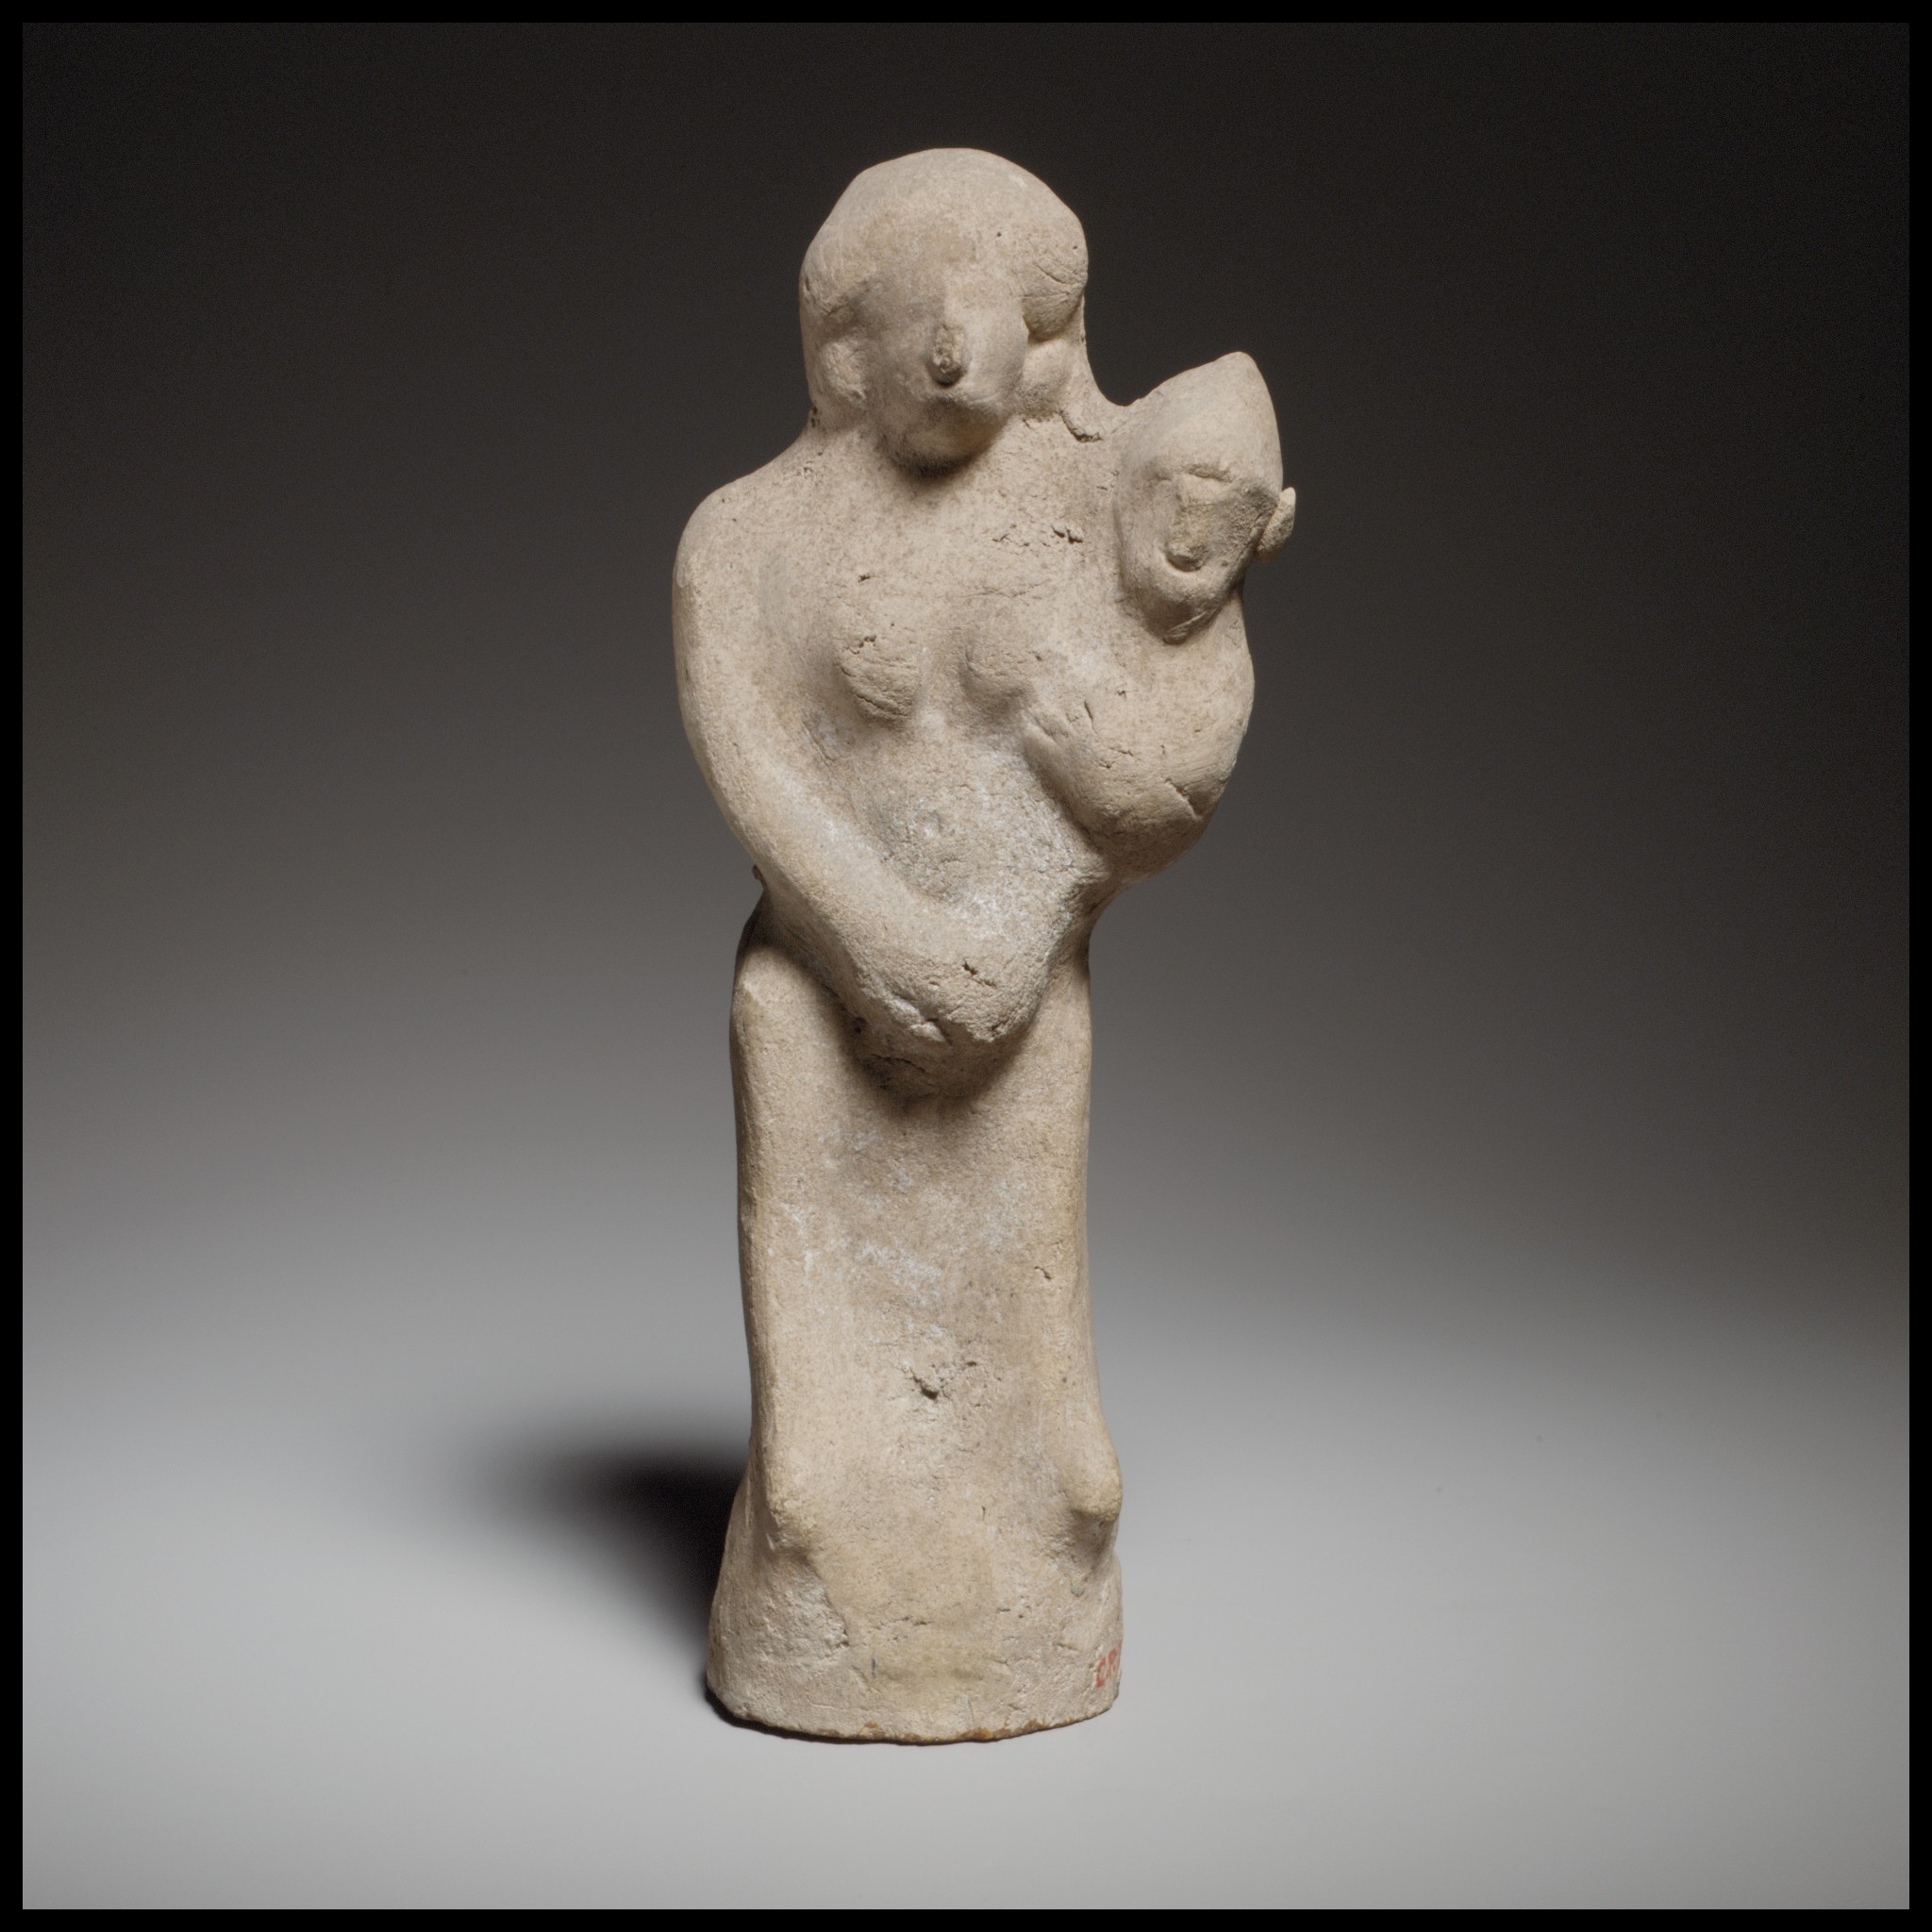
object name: statuette of a woman with infant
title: Seated female figurine holding a baby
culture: cypriot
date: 600-480 BCE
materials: terracotta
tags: infants,women